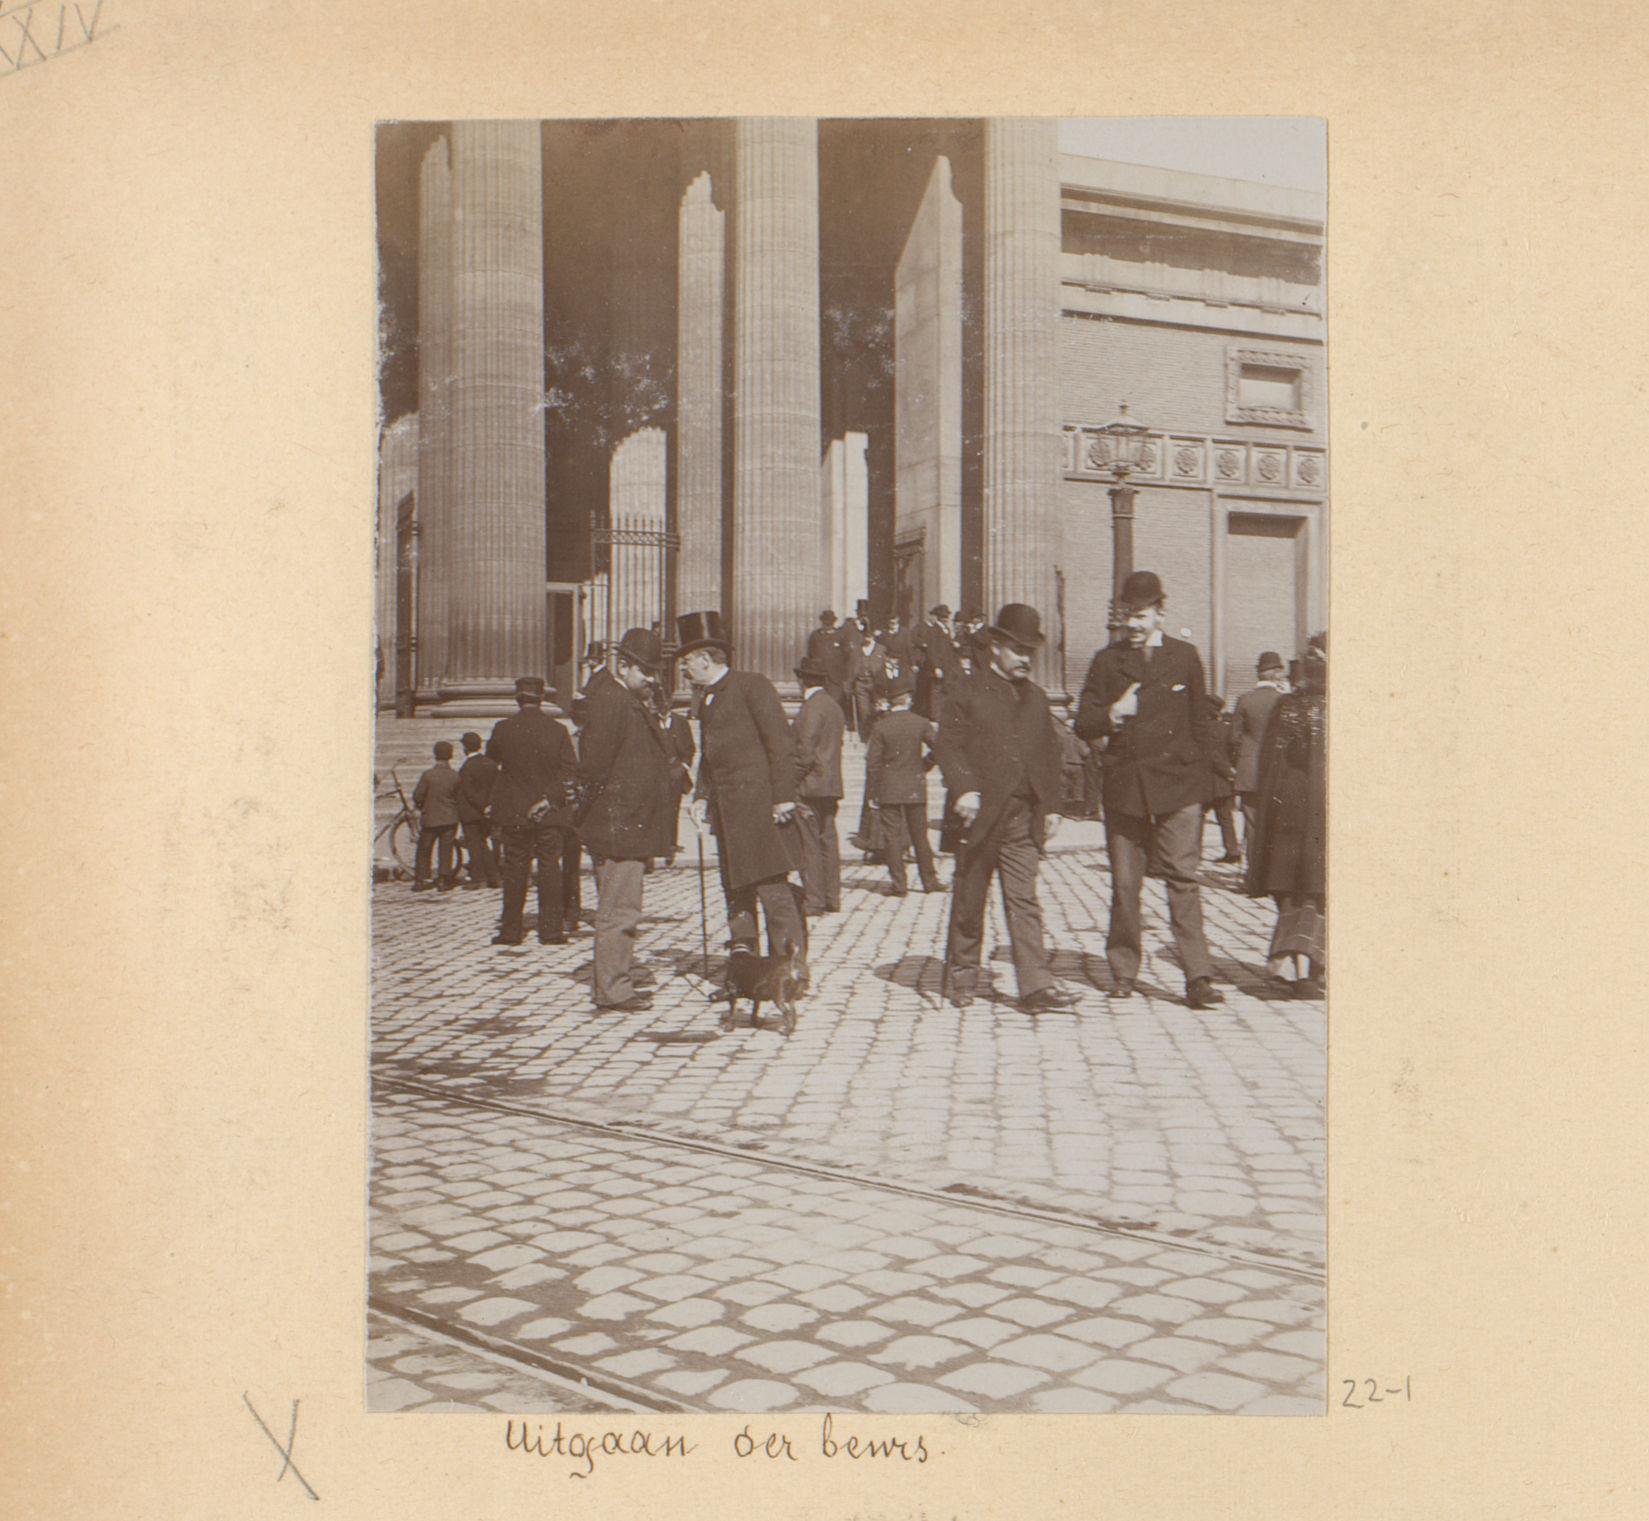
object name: photograph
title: Bankiers of handelaars voor de Beurs van Zocher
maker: hendrik herman van den berg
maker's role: amateurfotograaf, jurist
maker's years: 1875-1944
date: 1890-1894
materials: paper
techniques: collodion silver print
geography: amsterdam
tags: exchange, bourse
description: Foto 1 op albumblad 22 uit album "Amsterdam 1890-1894".